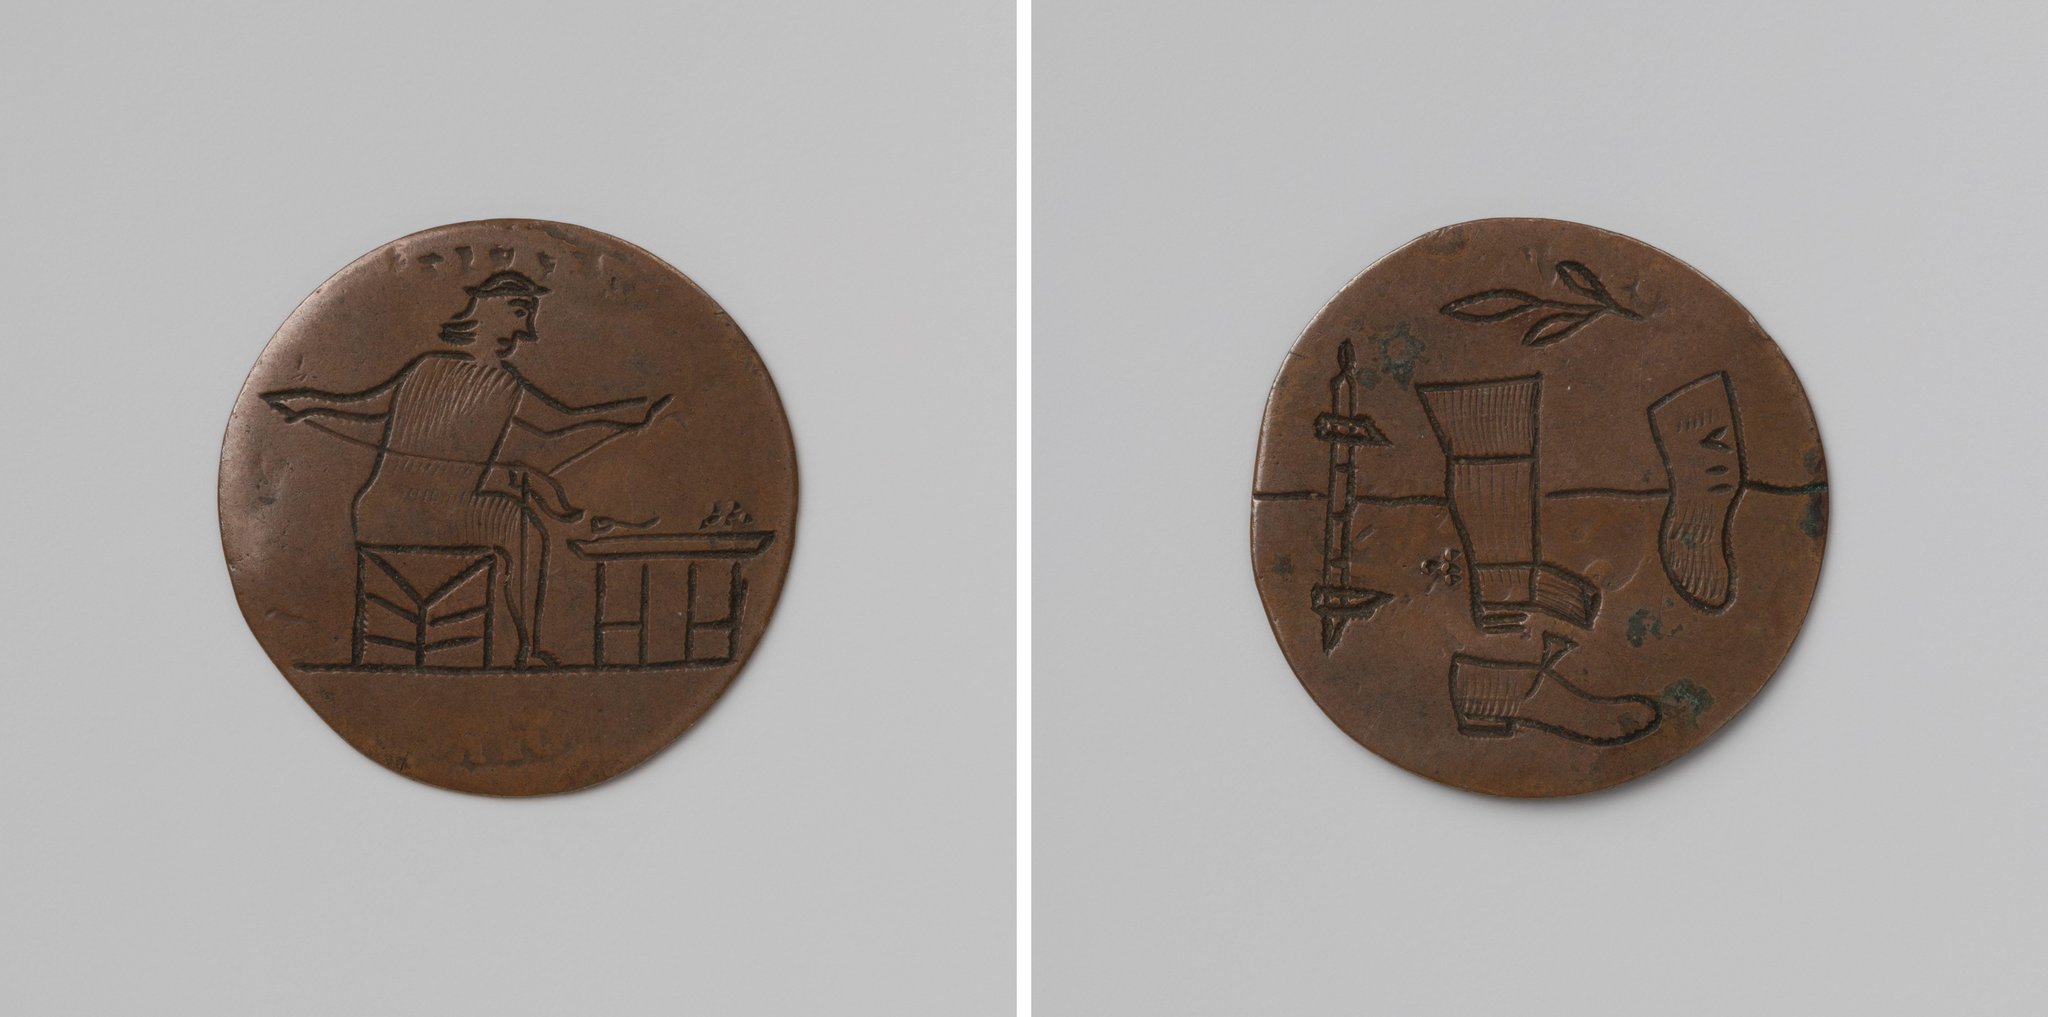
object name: medal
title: Schoenmakersgilde, gildepenning gegraveerd over een gesleten munt of rekenpenning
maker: Anonymous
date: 1600-1750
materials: copper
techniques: engraving, striking